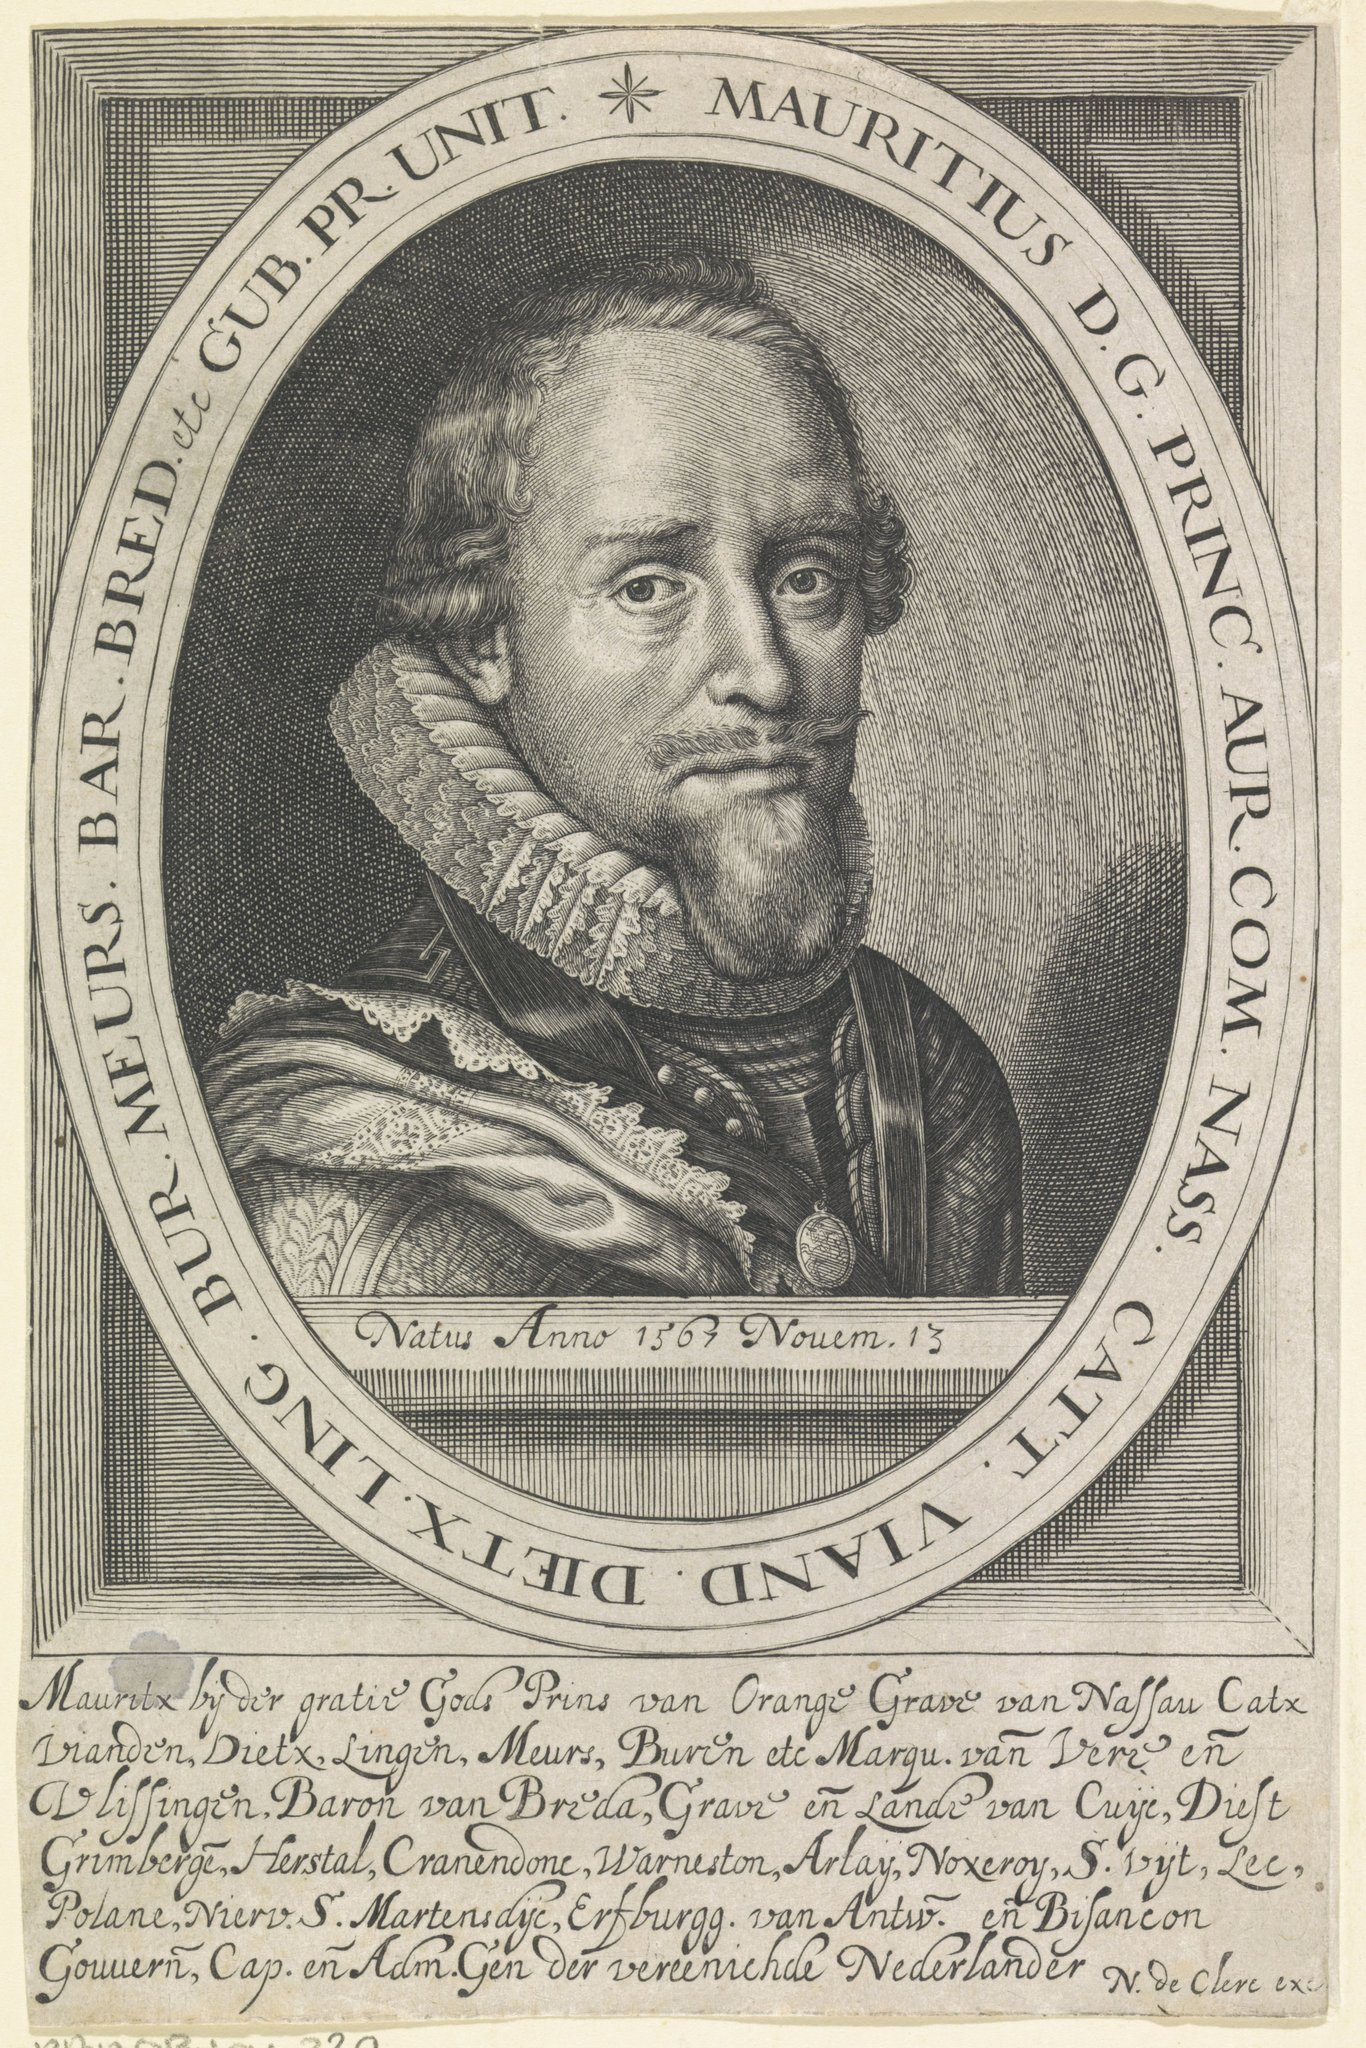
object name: print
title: Portret van Maurits, prins van Oranje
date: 1612-1625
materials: paper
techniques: engraving, etching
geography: northern netherlands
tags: the hague, maurice (prince of orange), knighthood order (garter) - insignia of a knighthood order, e.g.: badge, chain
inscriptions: collector's mark: Lugt 2228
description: De hier vermelde titel verwijst naar de hoogst verkregen titel van de geportretteerde, niet per se naar de titel die de geportretteerde op deze voorstelling draagt.